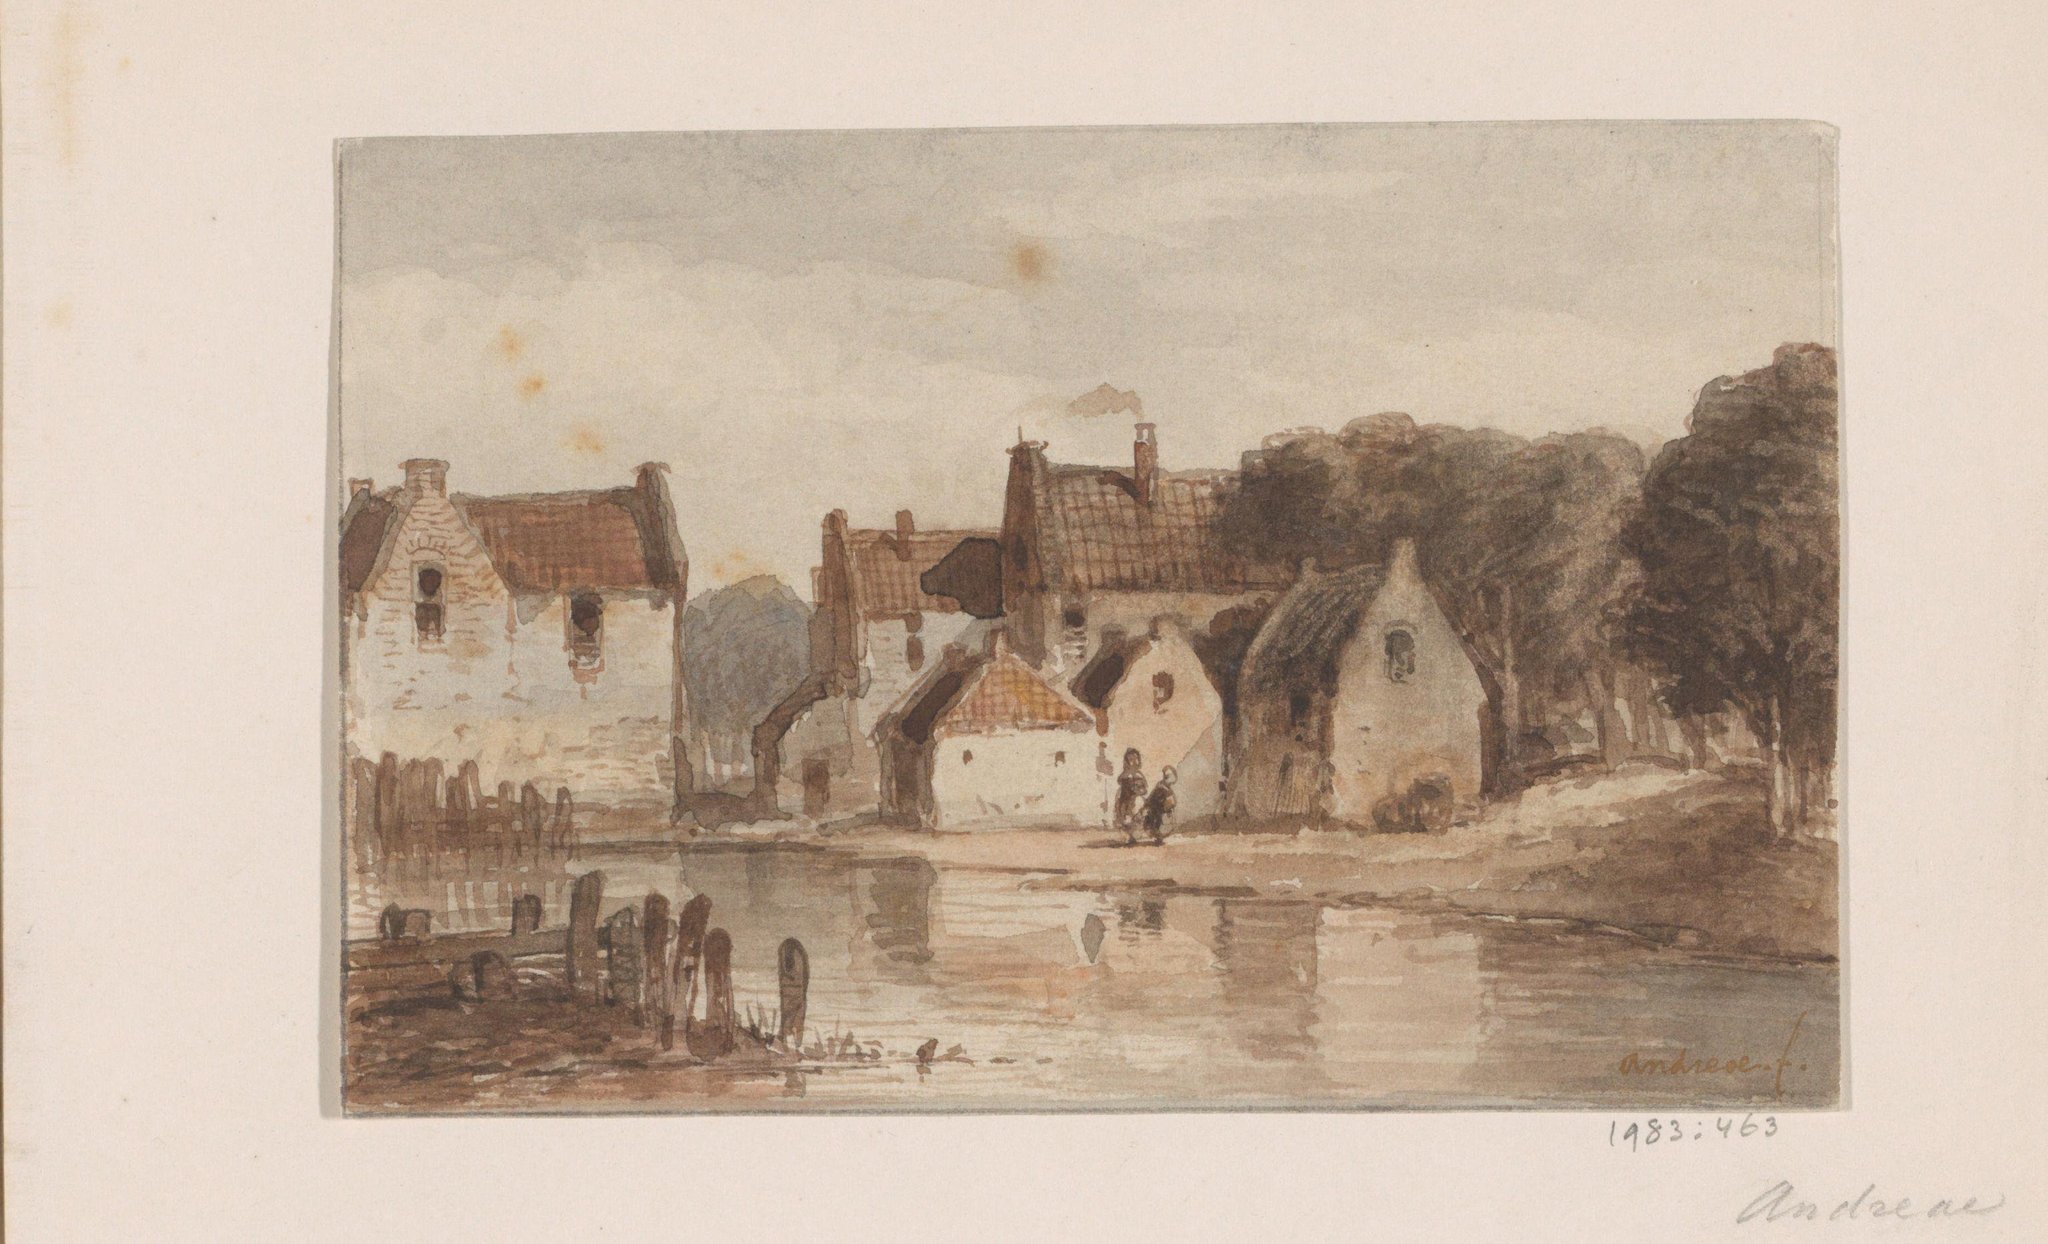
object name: drawing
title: Huizen aan een vaart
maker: andreae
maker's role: draughtsman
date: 1809-1876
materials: paper, watercolor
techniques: brush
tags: landscapes with waters, waterscapes, seascapes (in the temperate zone), prospect of village, silhouette of village (+ city(-scape) with figures, staffage)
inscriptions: signature: ‘Andreae. f.’